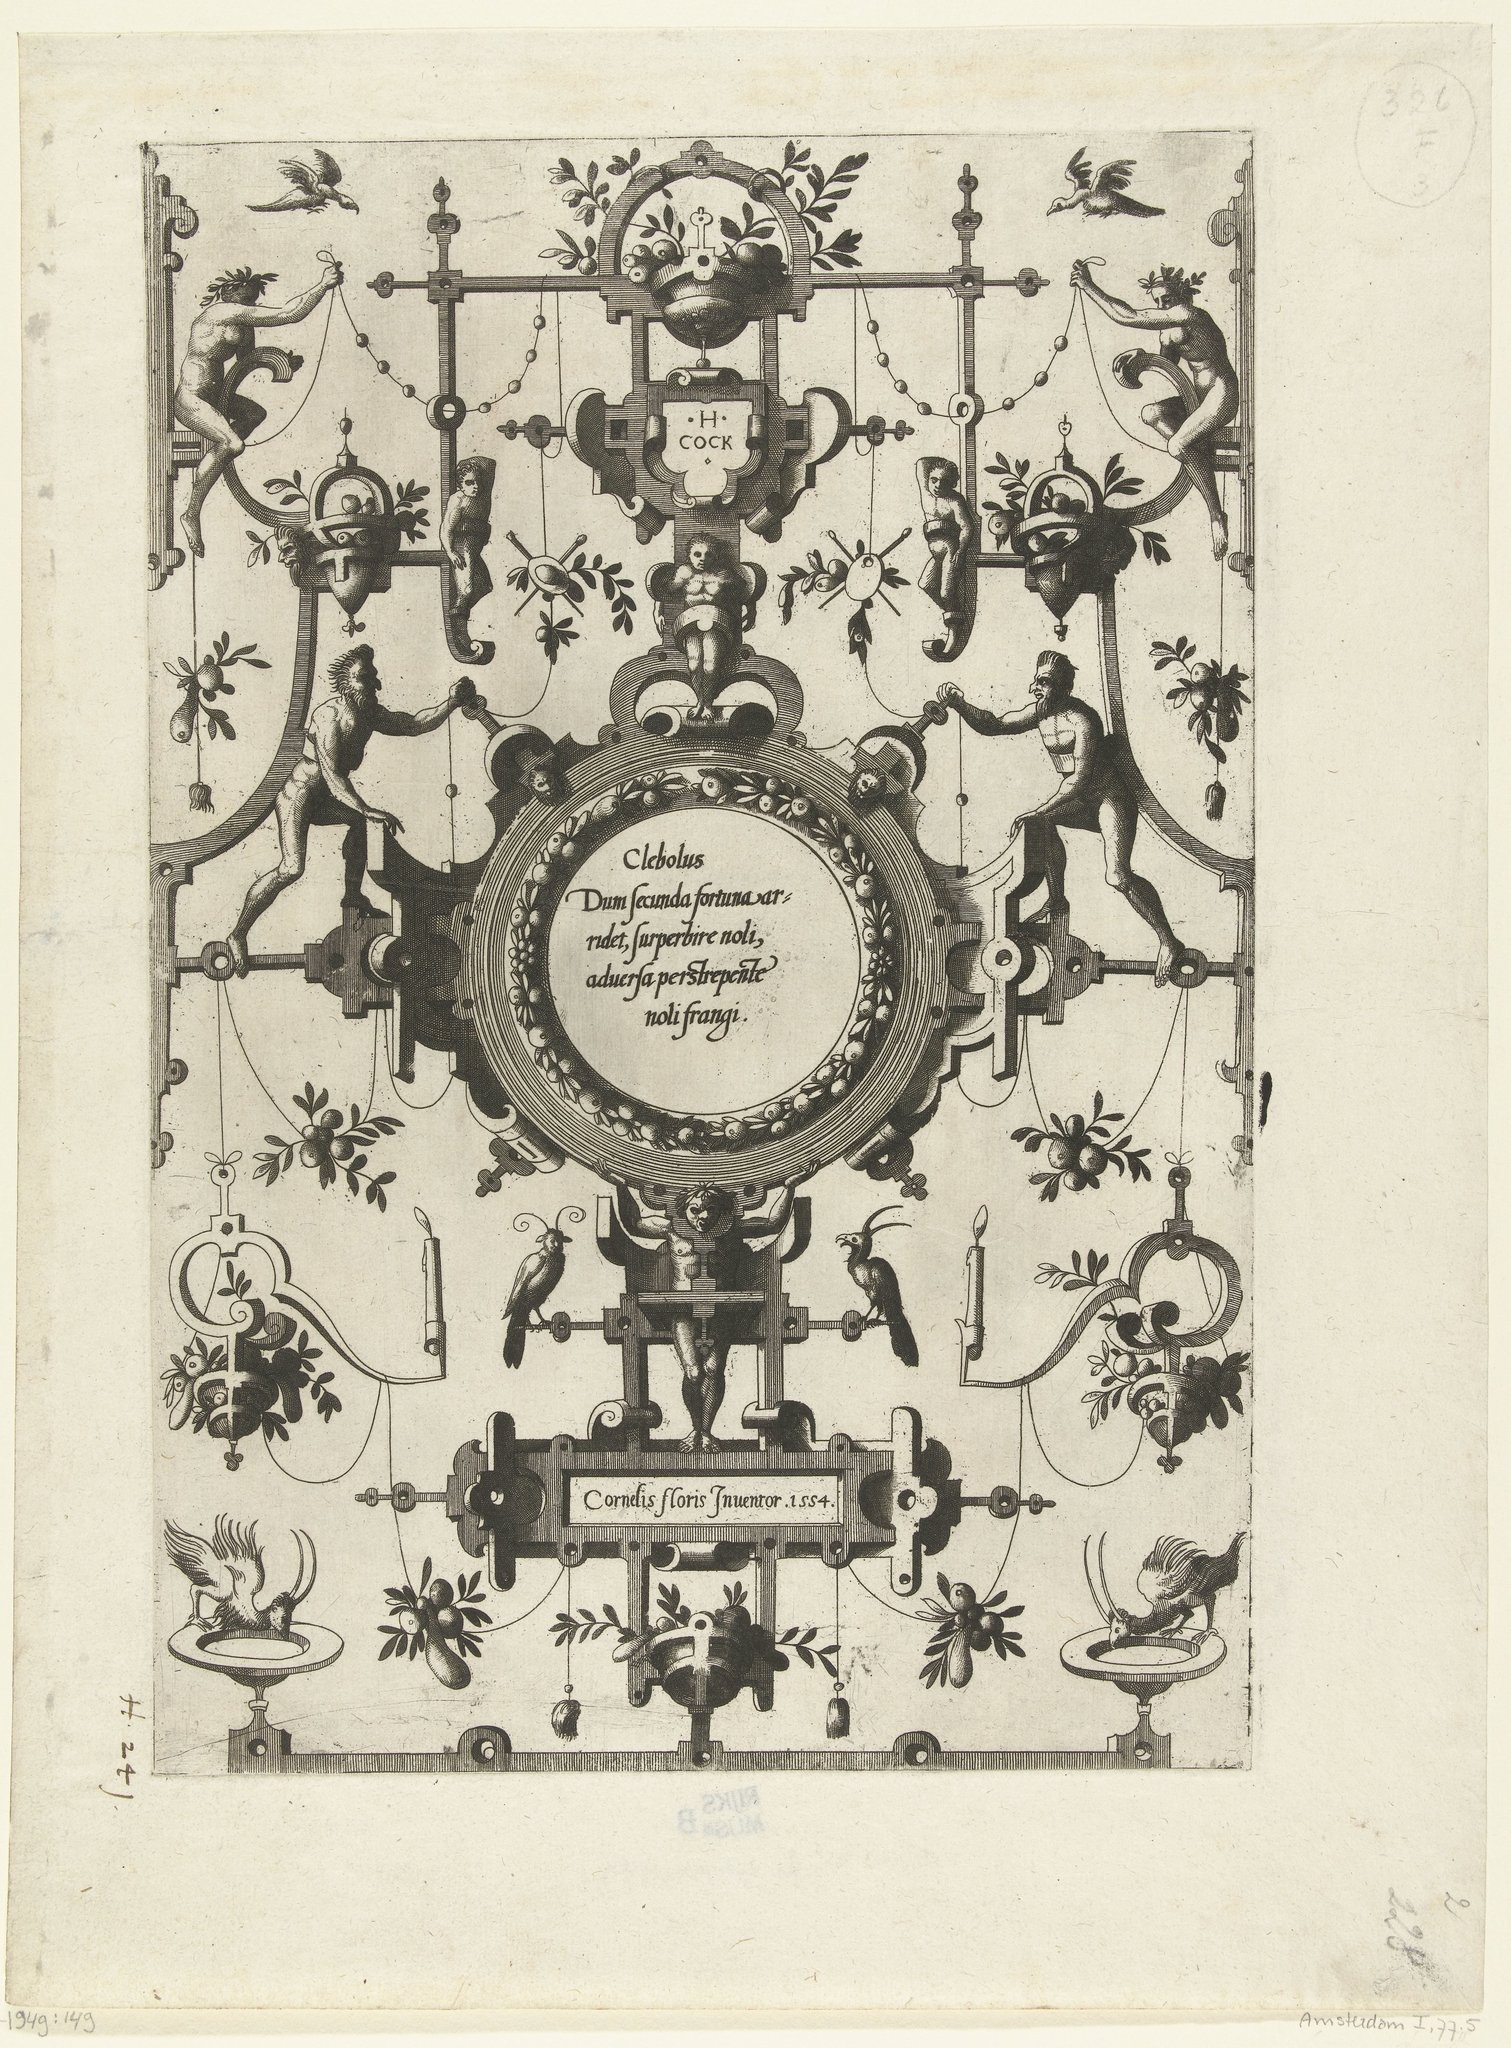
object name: ornament print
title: Vlakdecoraties: cartouches met citaten van filosofen in een omlijsting van rolwerk, grotesken, figuren, guirlandes en trofeeën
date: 1558-1630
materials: paper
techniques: etching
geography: netherlands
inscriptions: number: ‘H. 241’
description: Cartouche wordt gedragen door een atlant in rolwerk. Linksonder en rechtsonder drinkt een vogel uit een schaal. Hoort bij serie van 6 bladen.